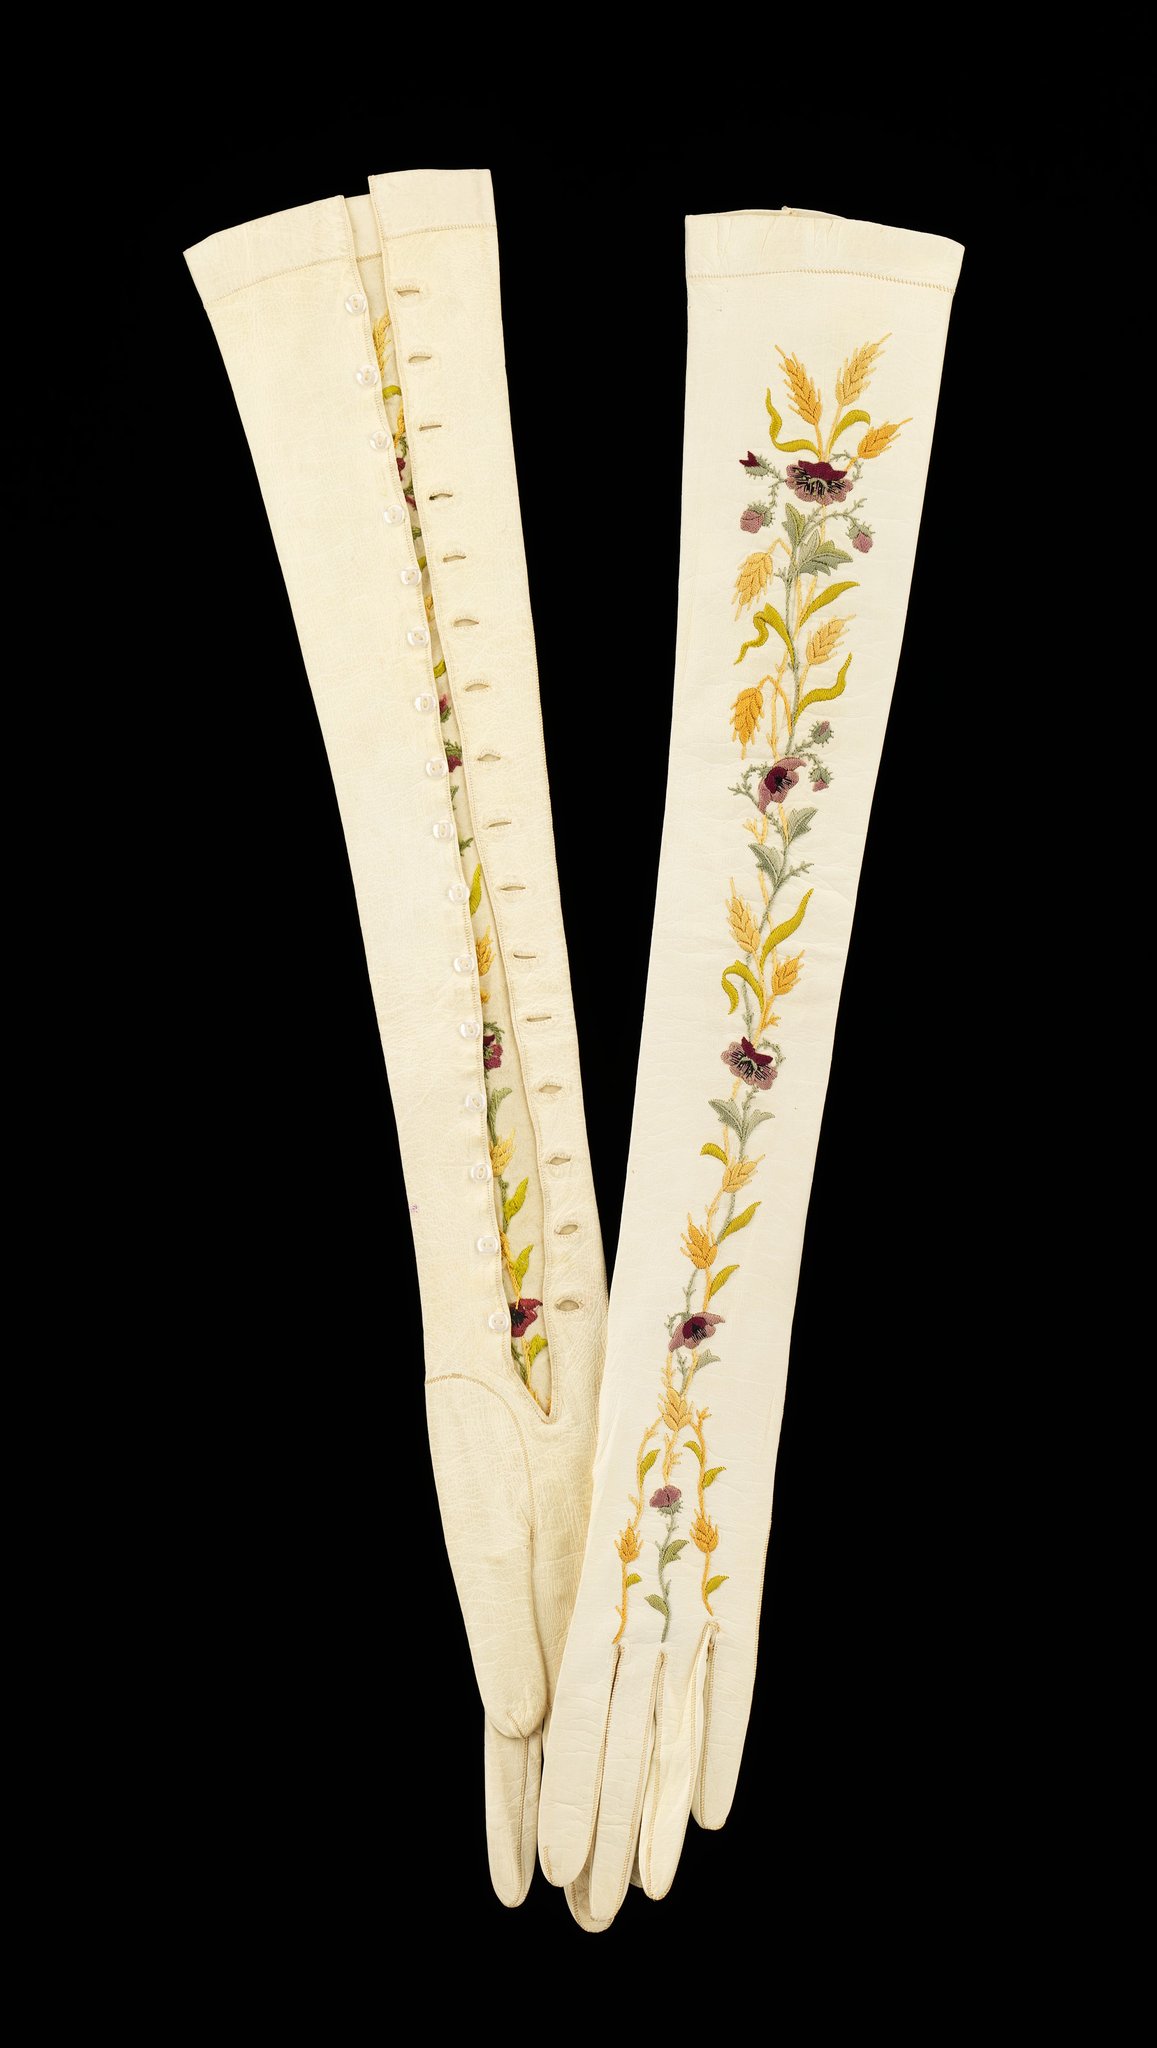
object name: evening glove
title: Evening gloves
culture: french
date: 1876-1900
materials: leather, silk